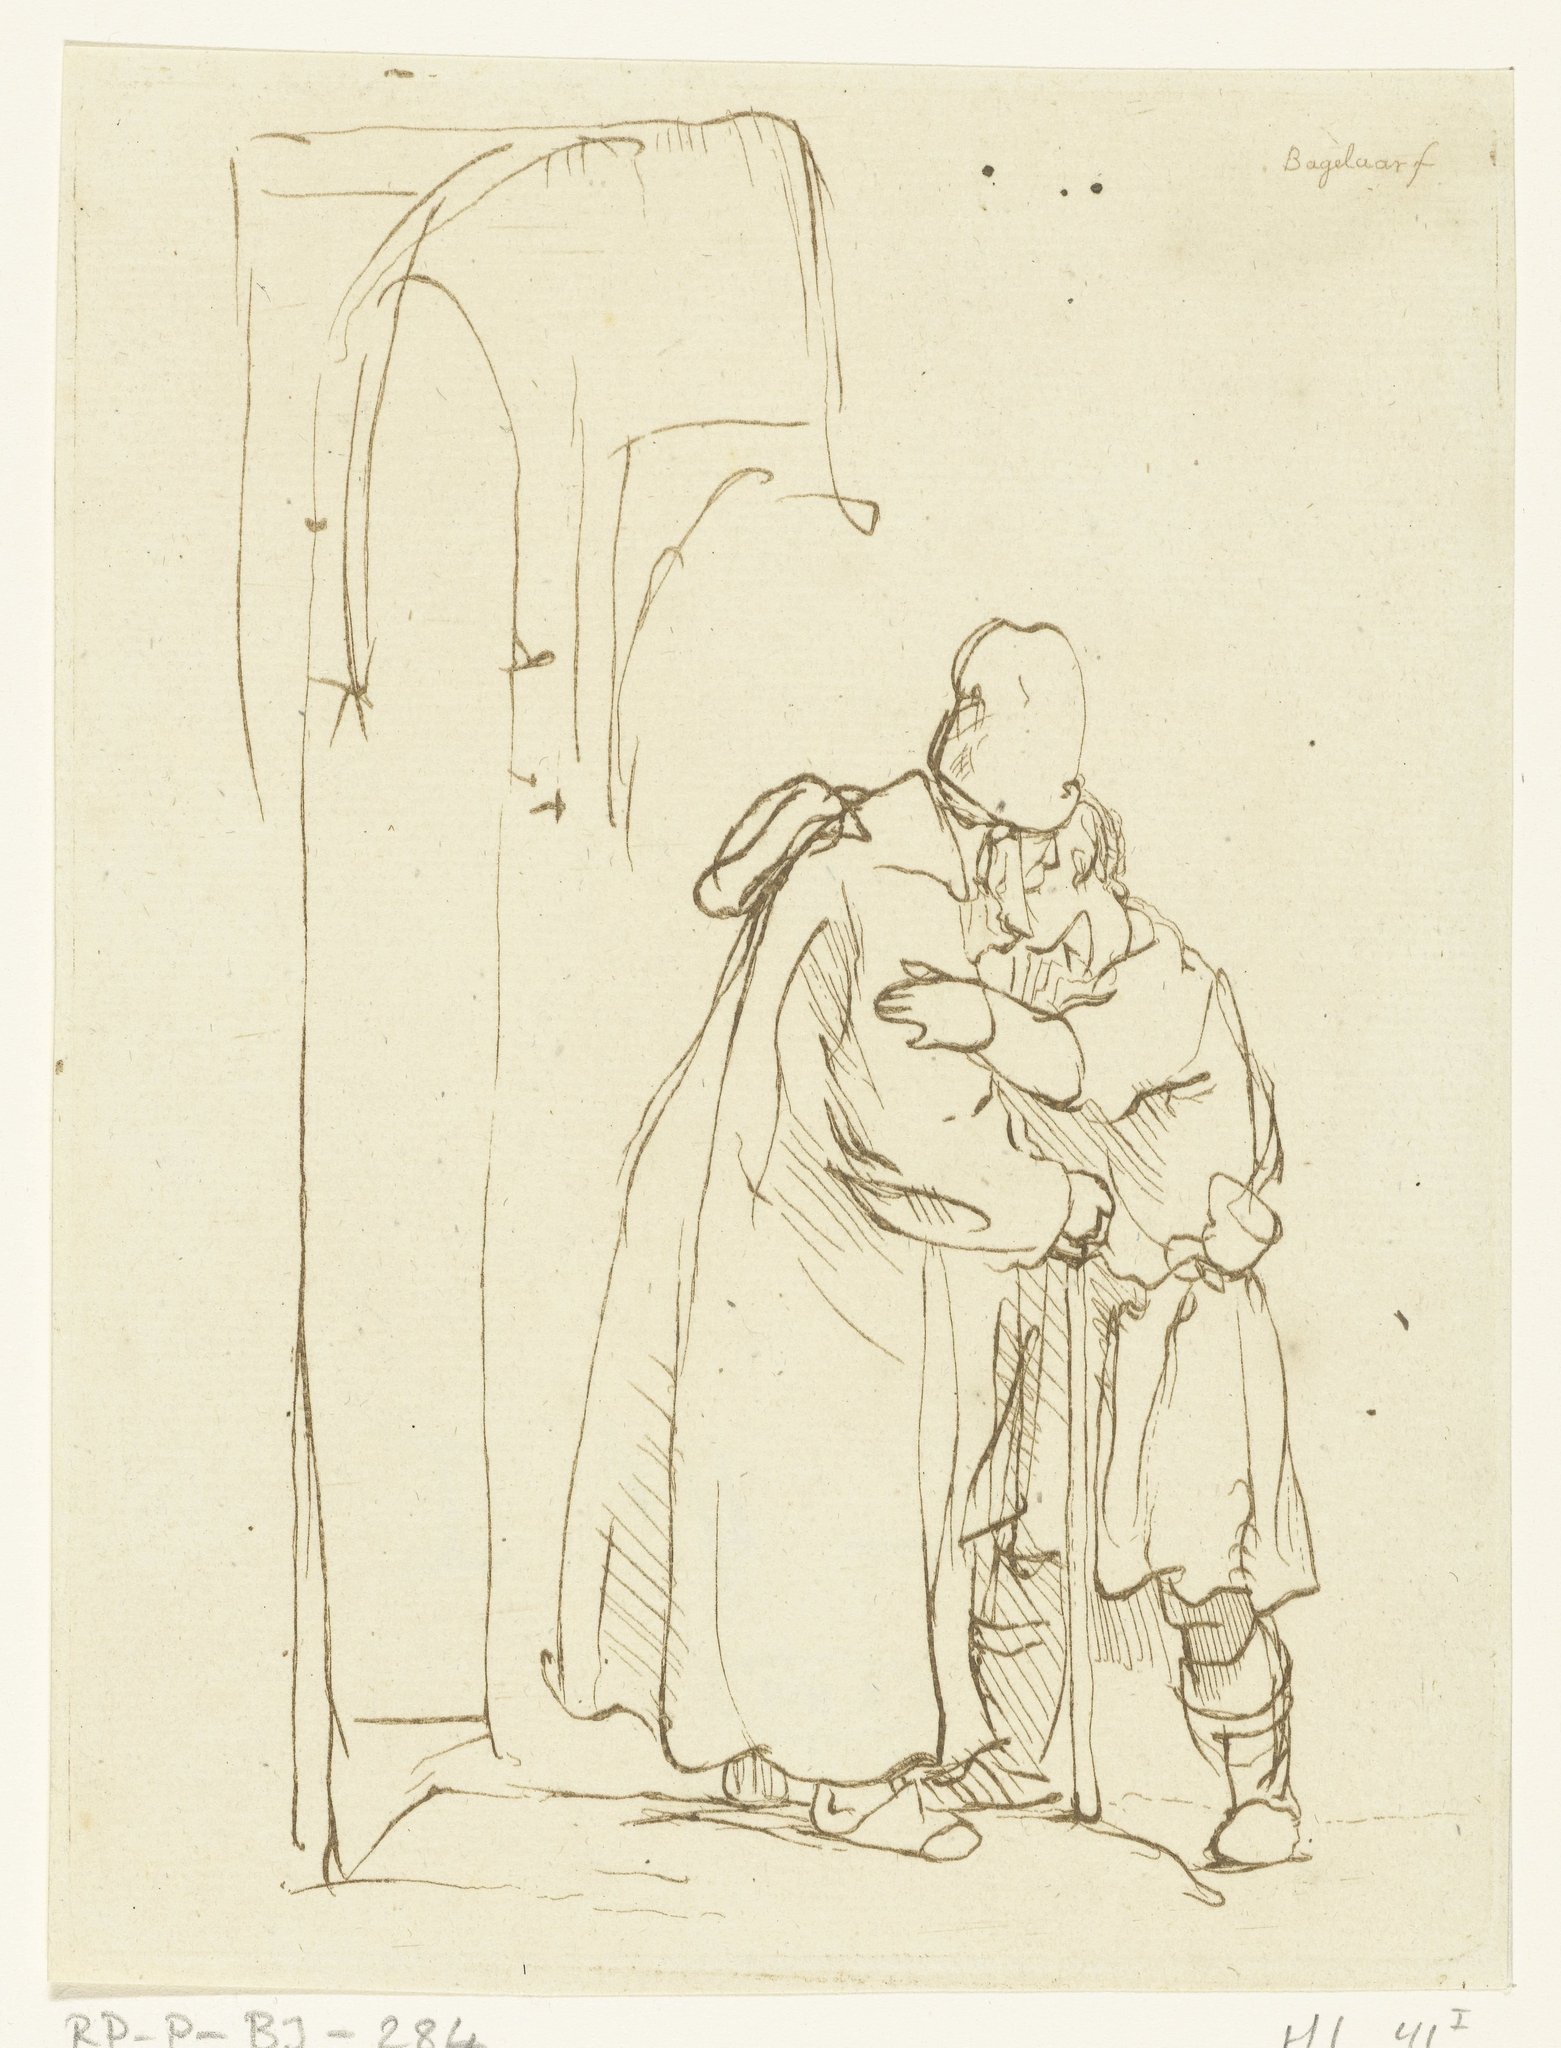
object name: print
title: De thuiskomst van de jonge Tobias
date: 1798-1837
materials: paper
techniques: etching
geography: netherlands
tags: the meeting of parents and son ~ tobias' return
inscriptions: collector's mark: Lugt 2228